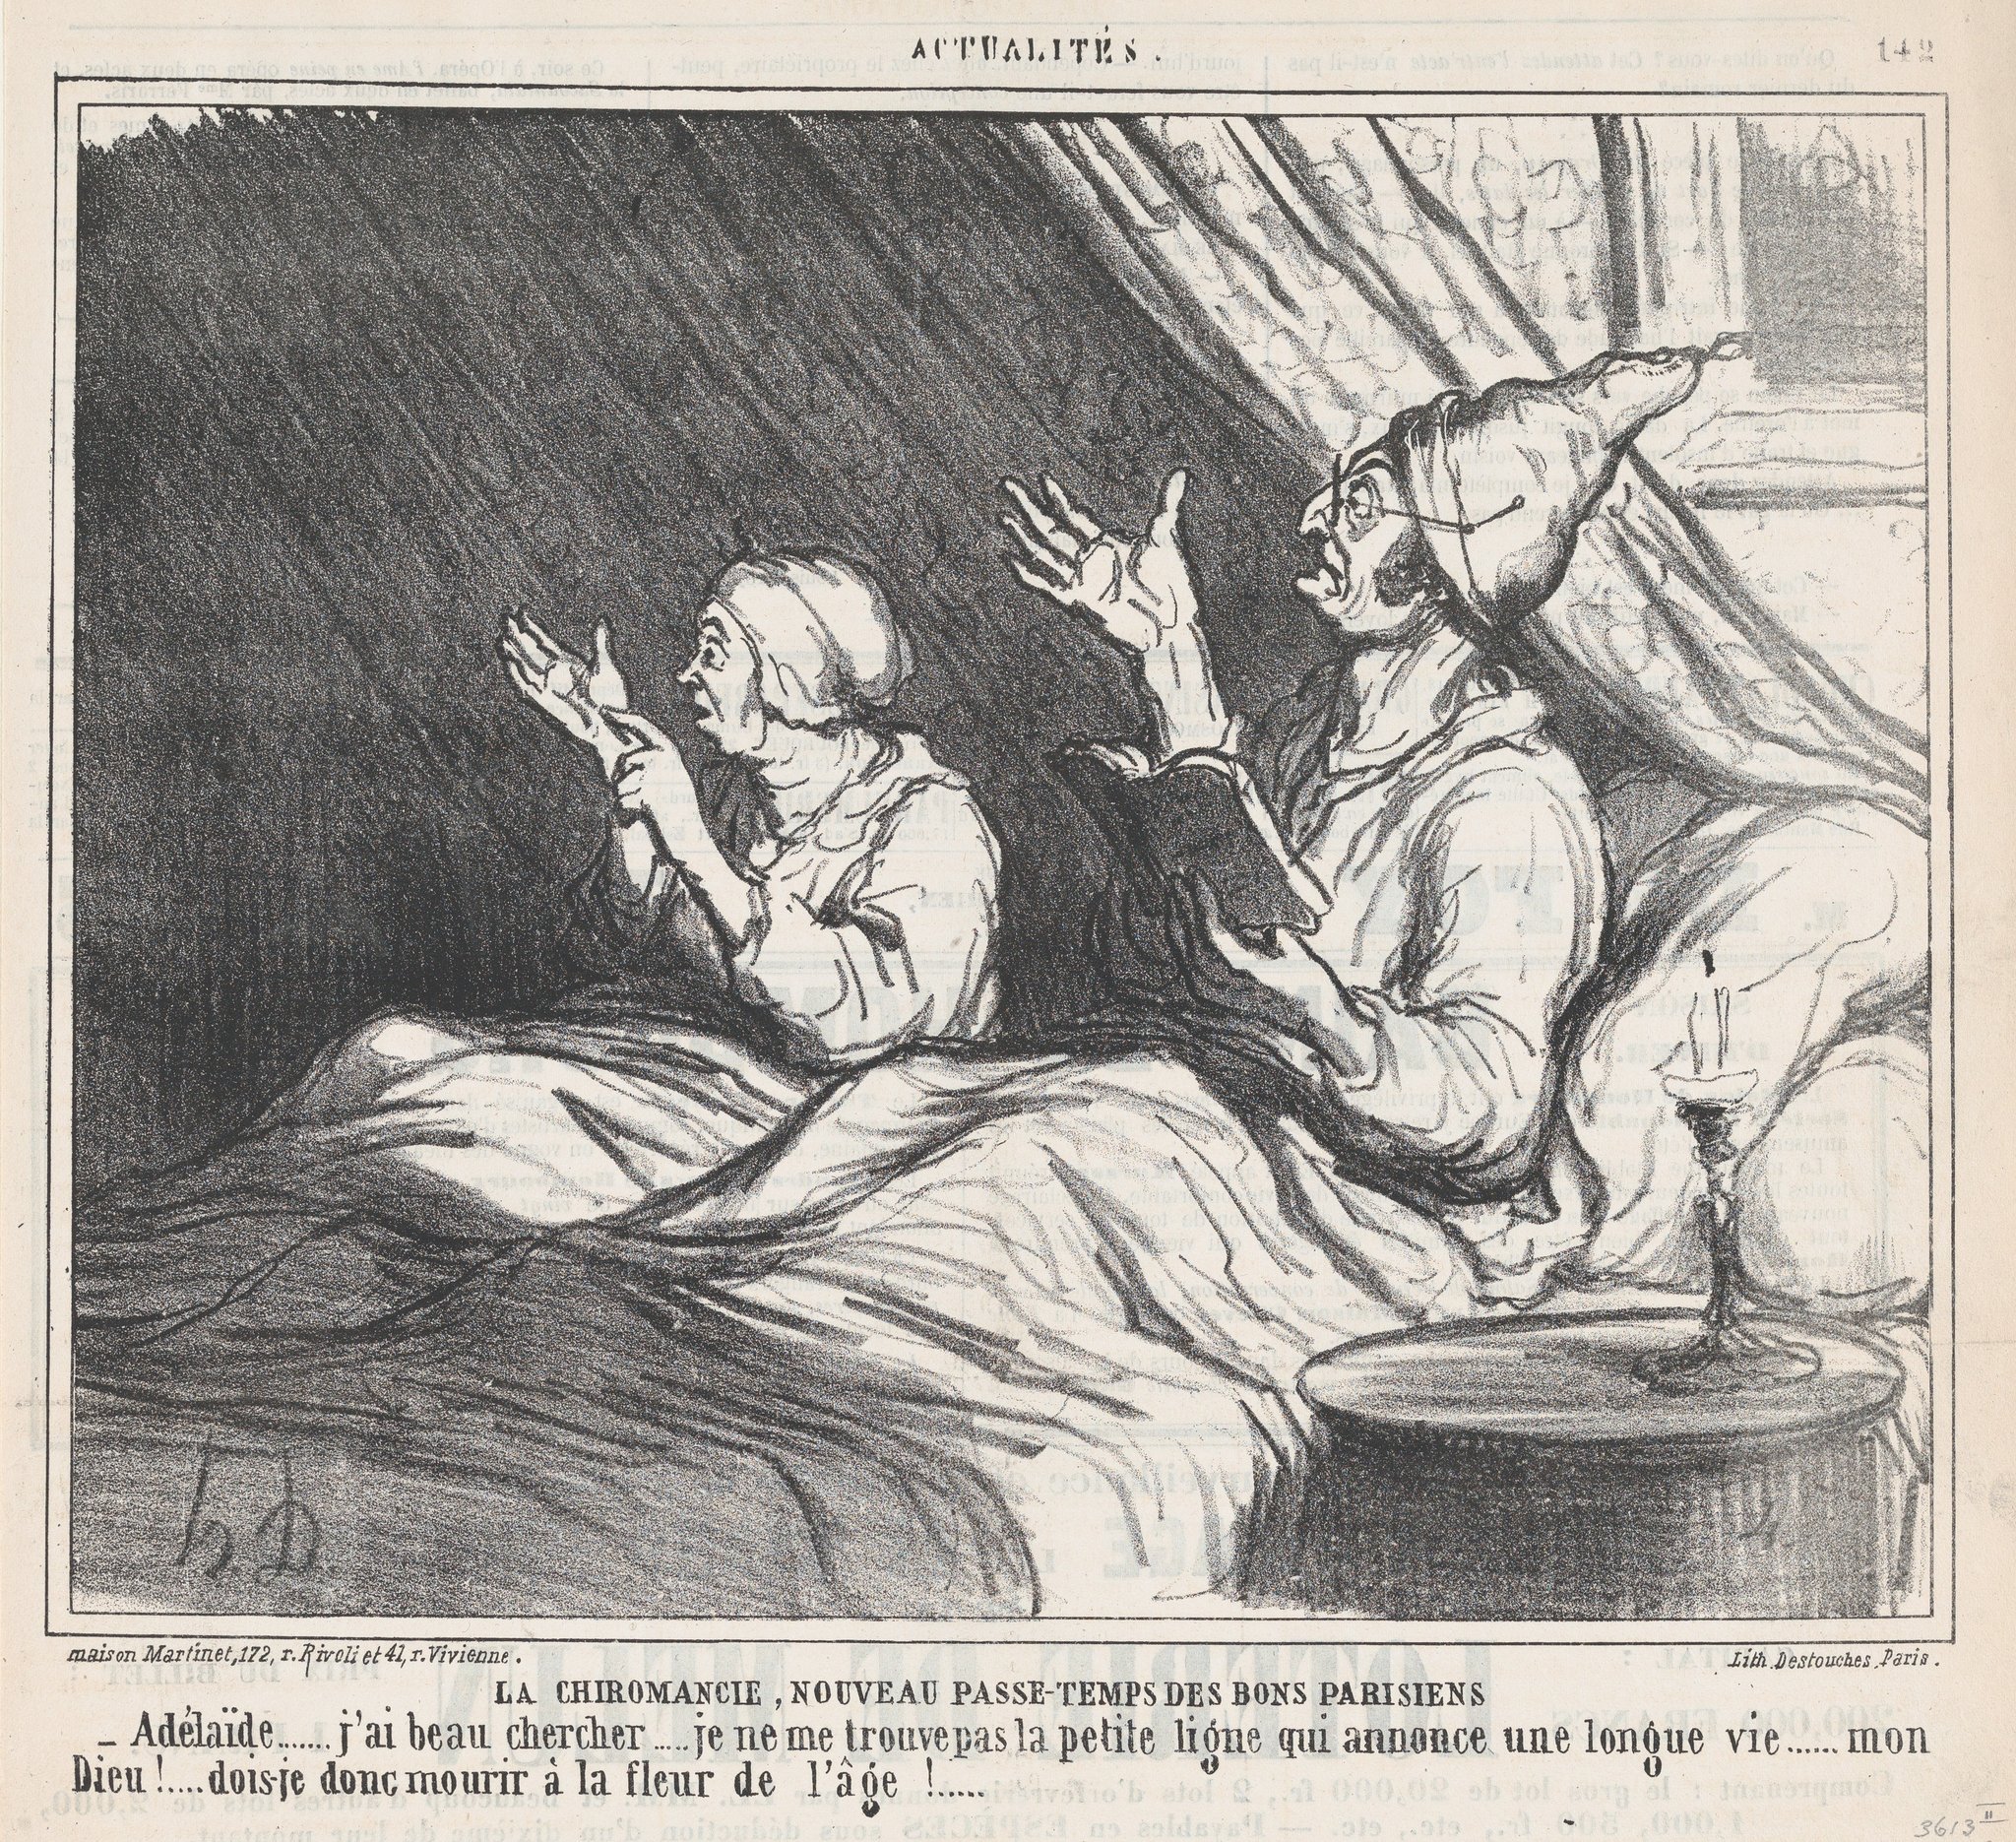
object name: print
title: Palmistry, New Parisian Pastime, from 'News of the Day,' published in Le Charivari, February 1, 1860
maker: honoré daumier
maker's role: artist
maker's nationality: french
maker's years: 1808-1879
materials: paper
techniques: lithograph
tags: men,women